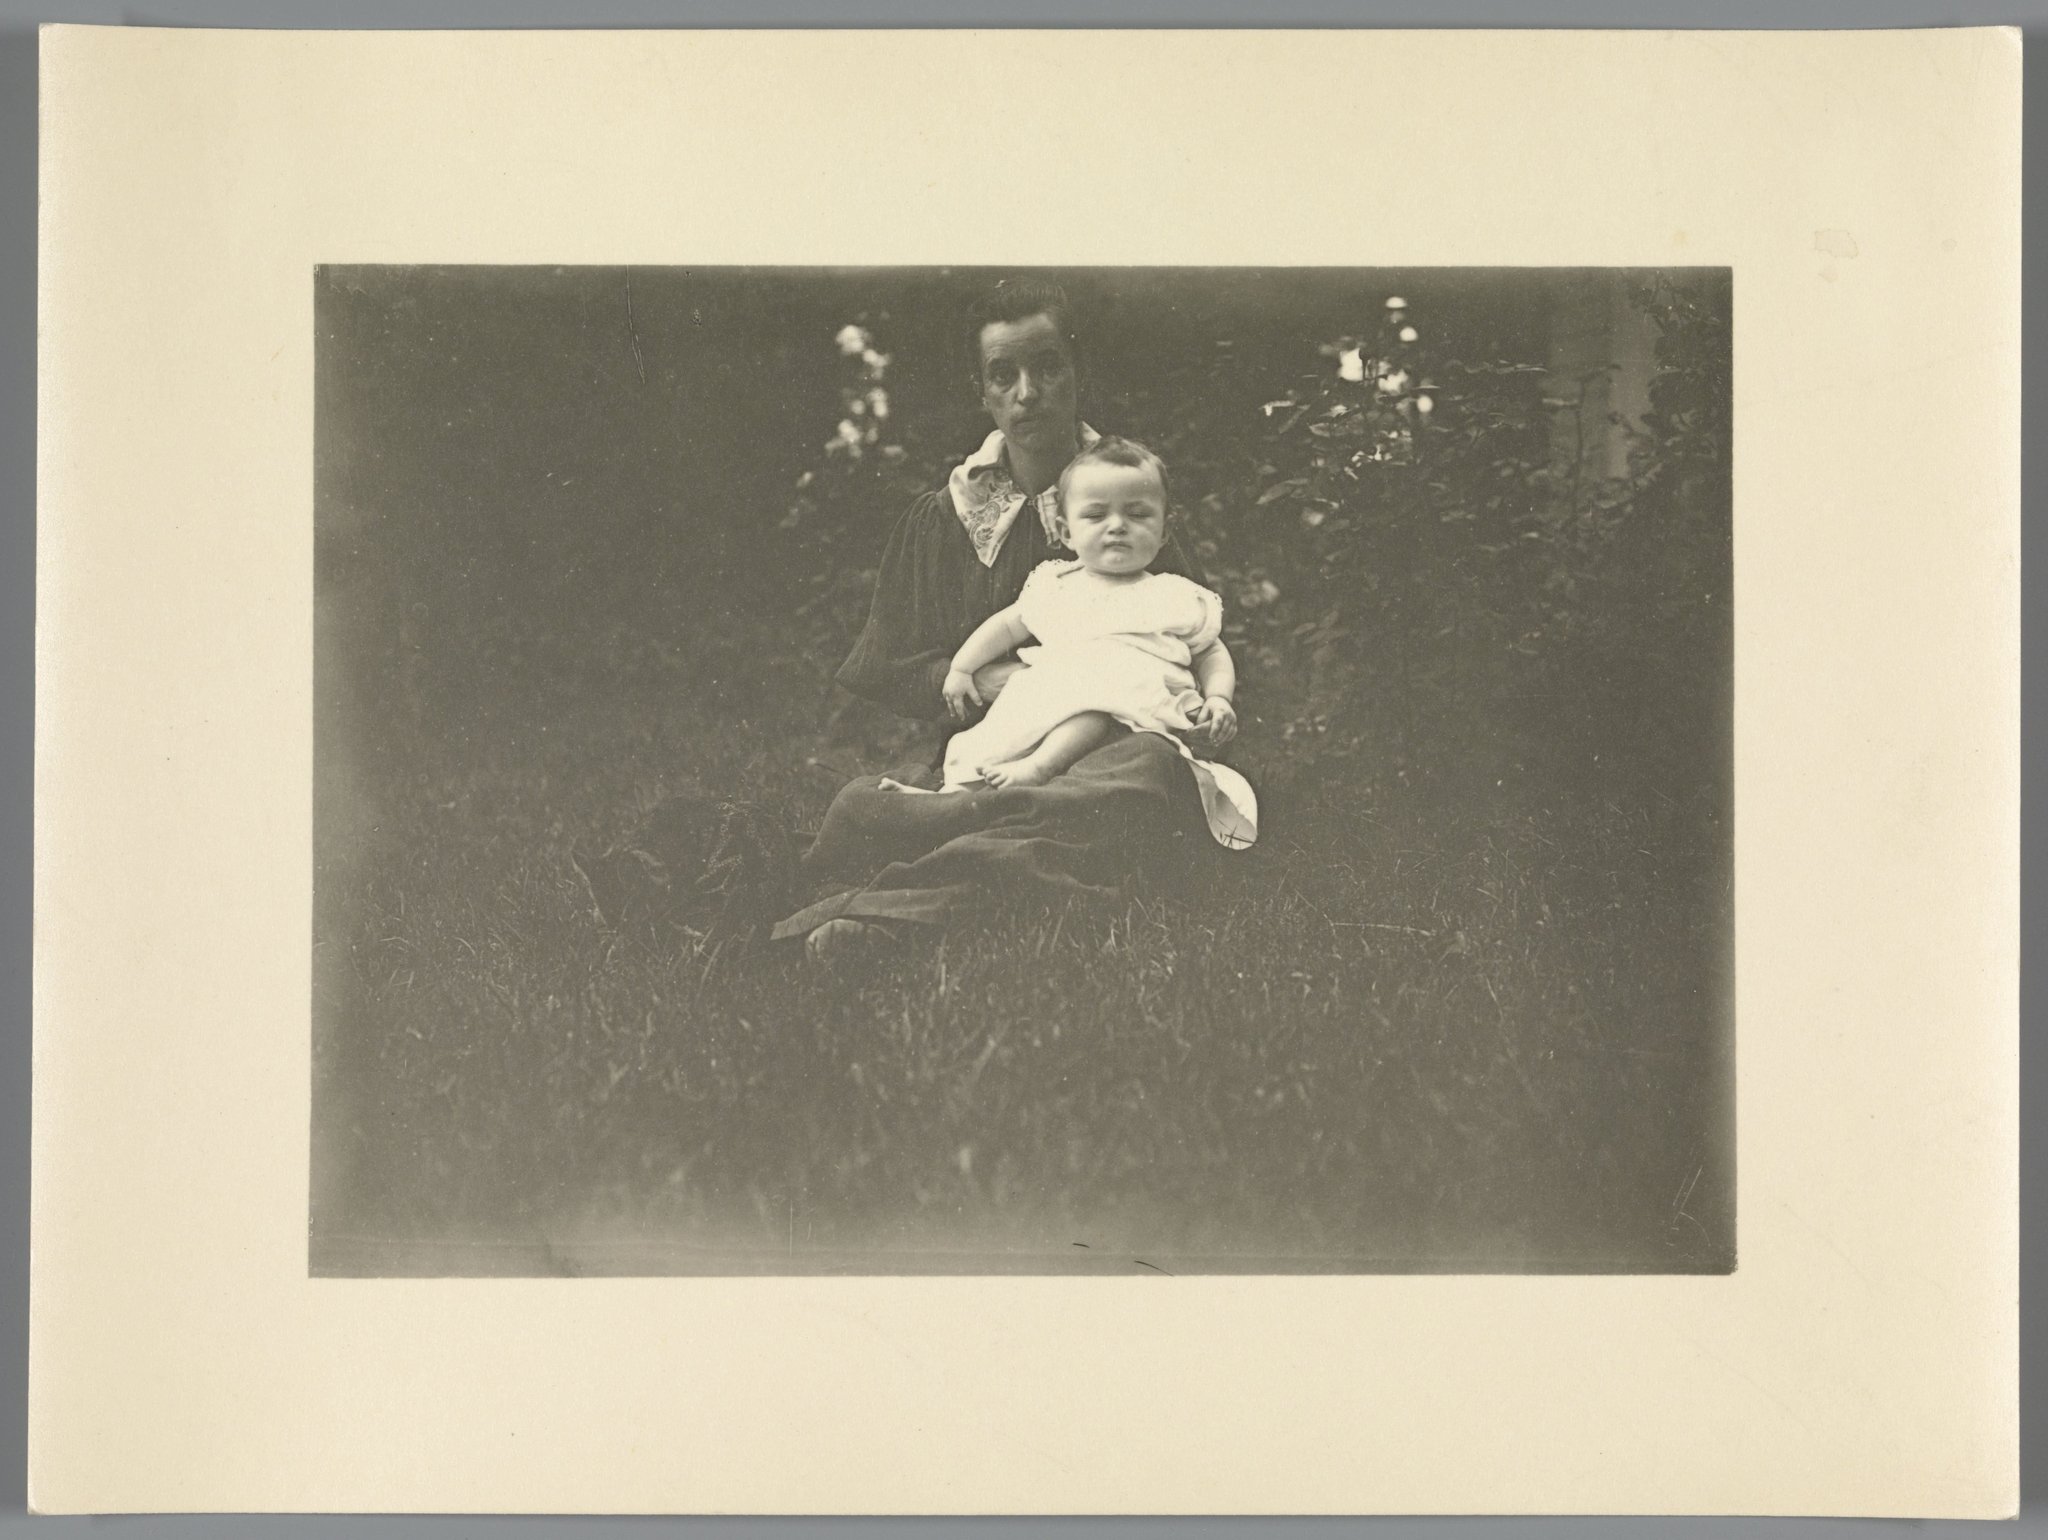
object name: photograph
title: Reproductie naar een foto van Willem Witsen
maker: Anonymous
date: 1860-1915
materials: paper, photographic support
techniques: gelatin silver print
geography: netherlands